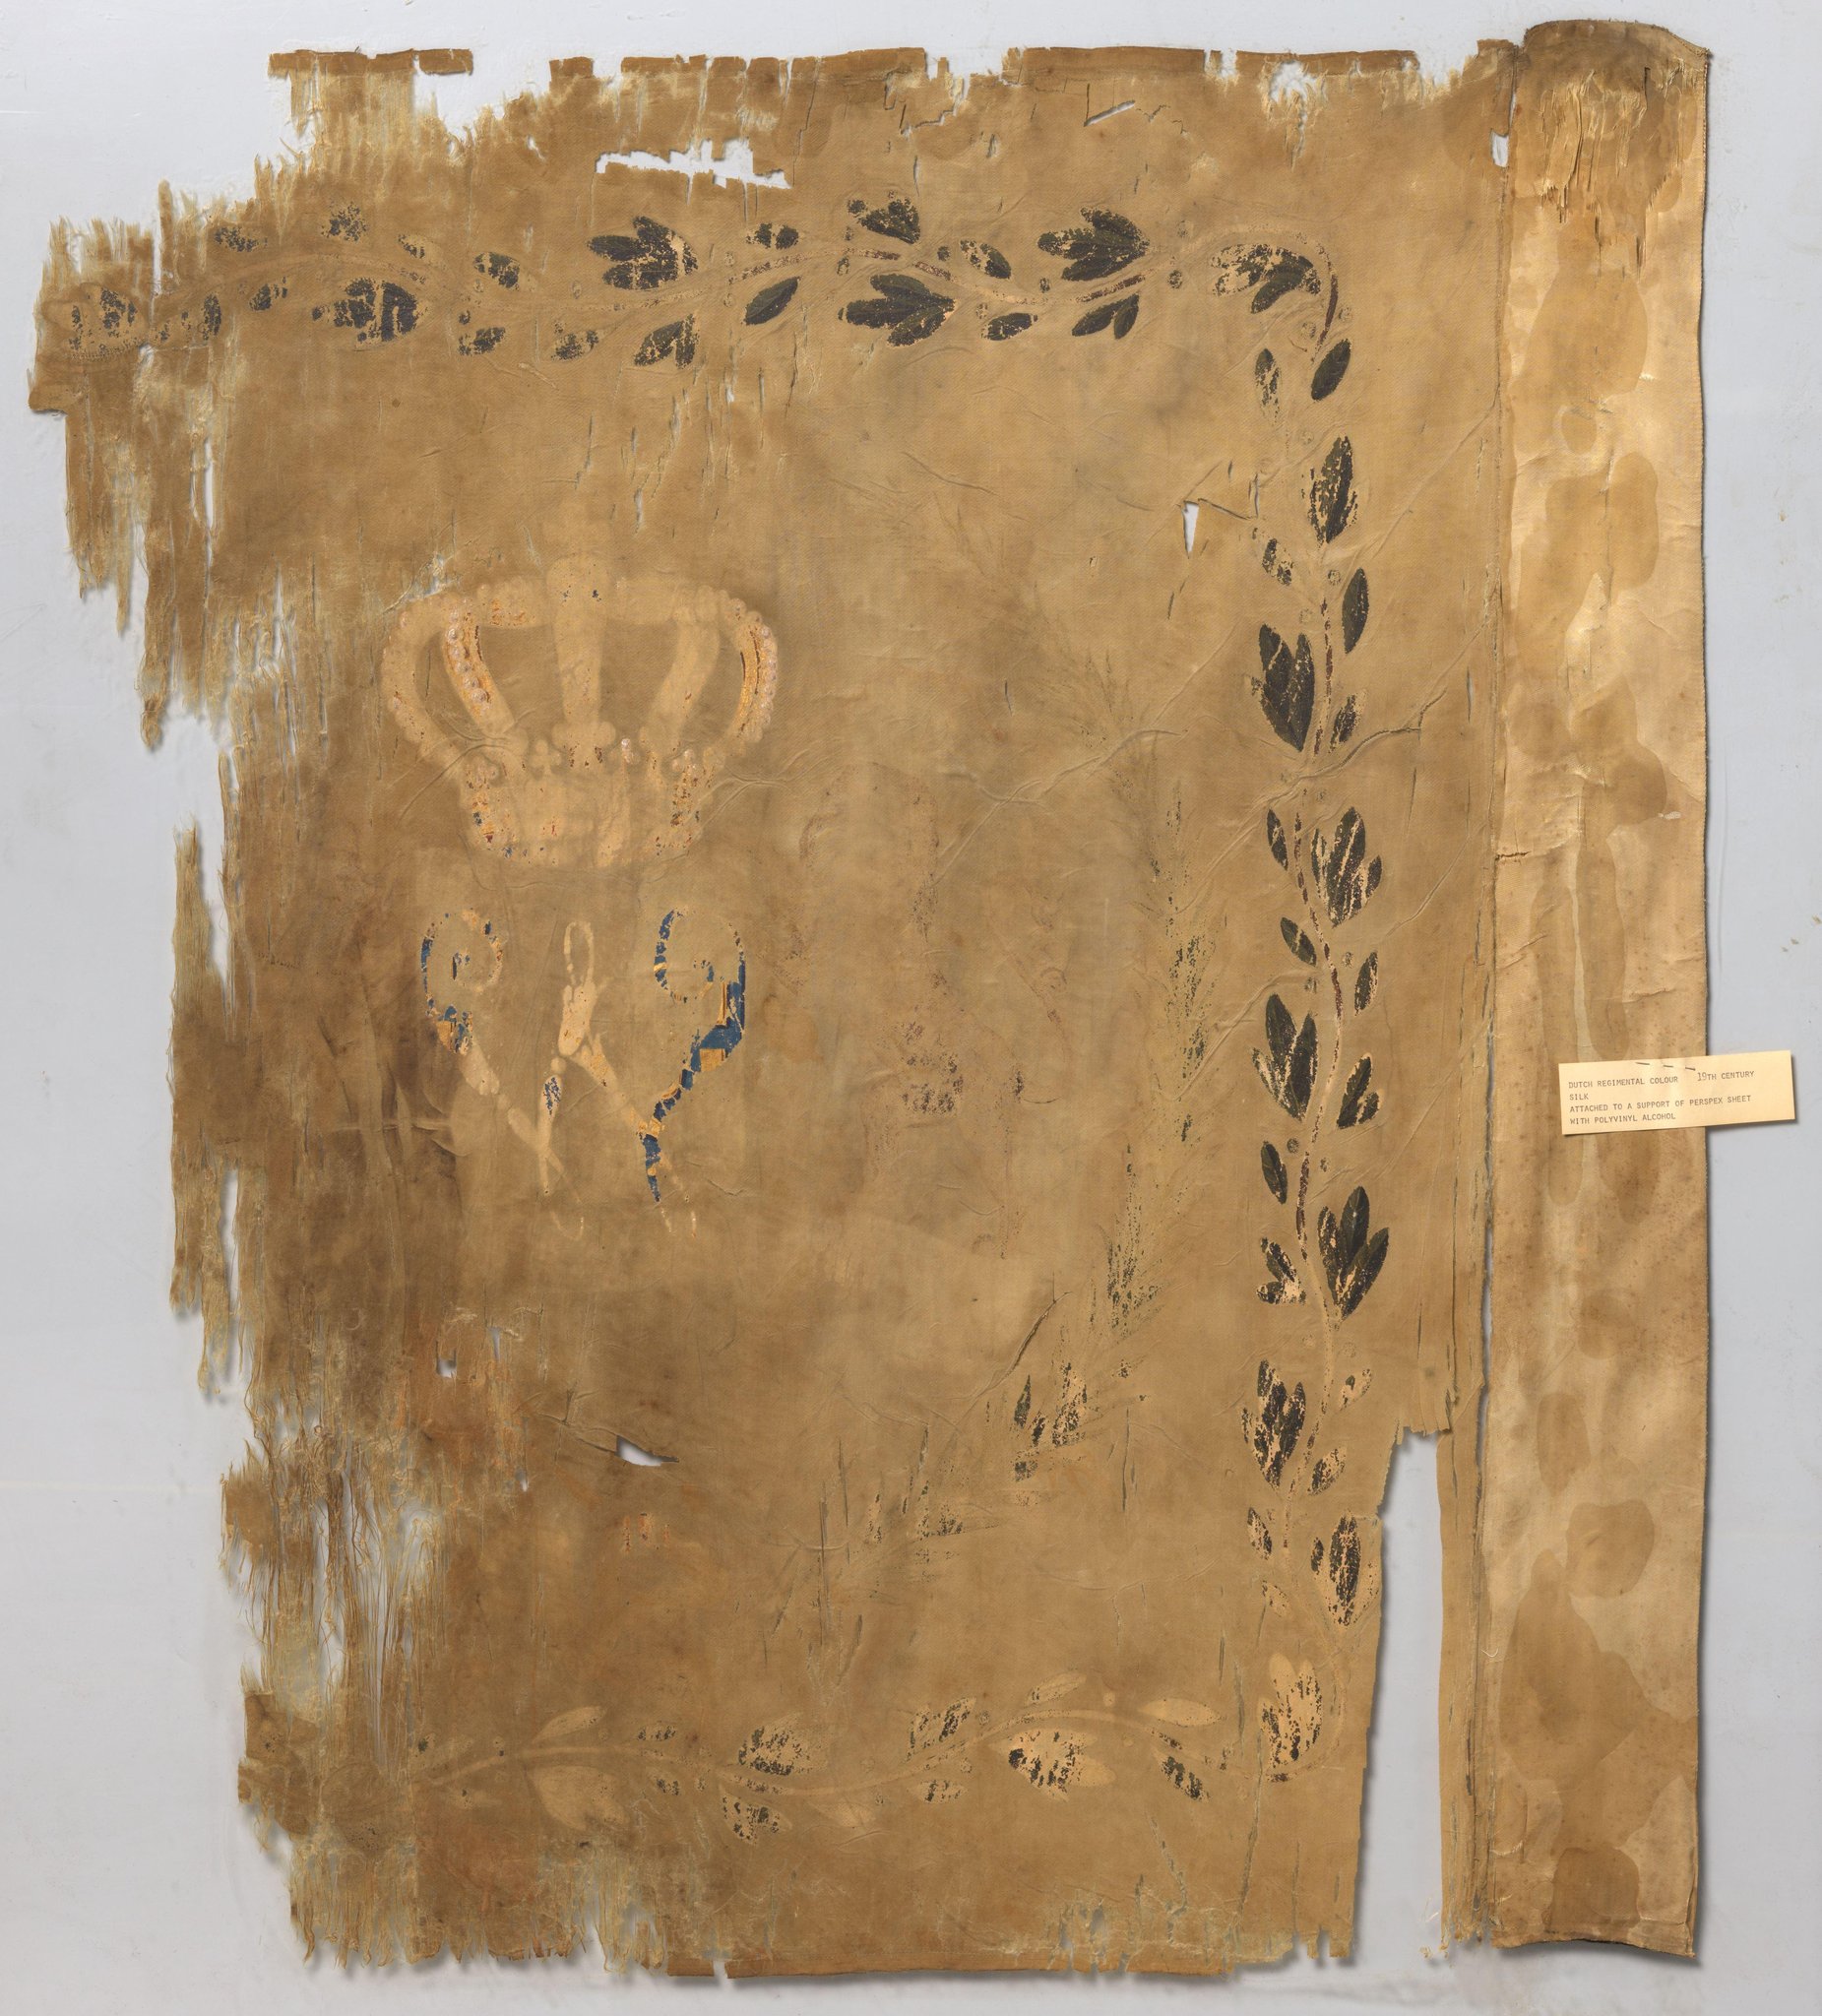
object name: banner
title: Fragment van een vaandel van de achttiende afdeling infanterie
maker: Anonymous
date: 1829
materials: gold thread, metal thread, paint, silk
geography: netherlands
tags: netherlands